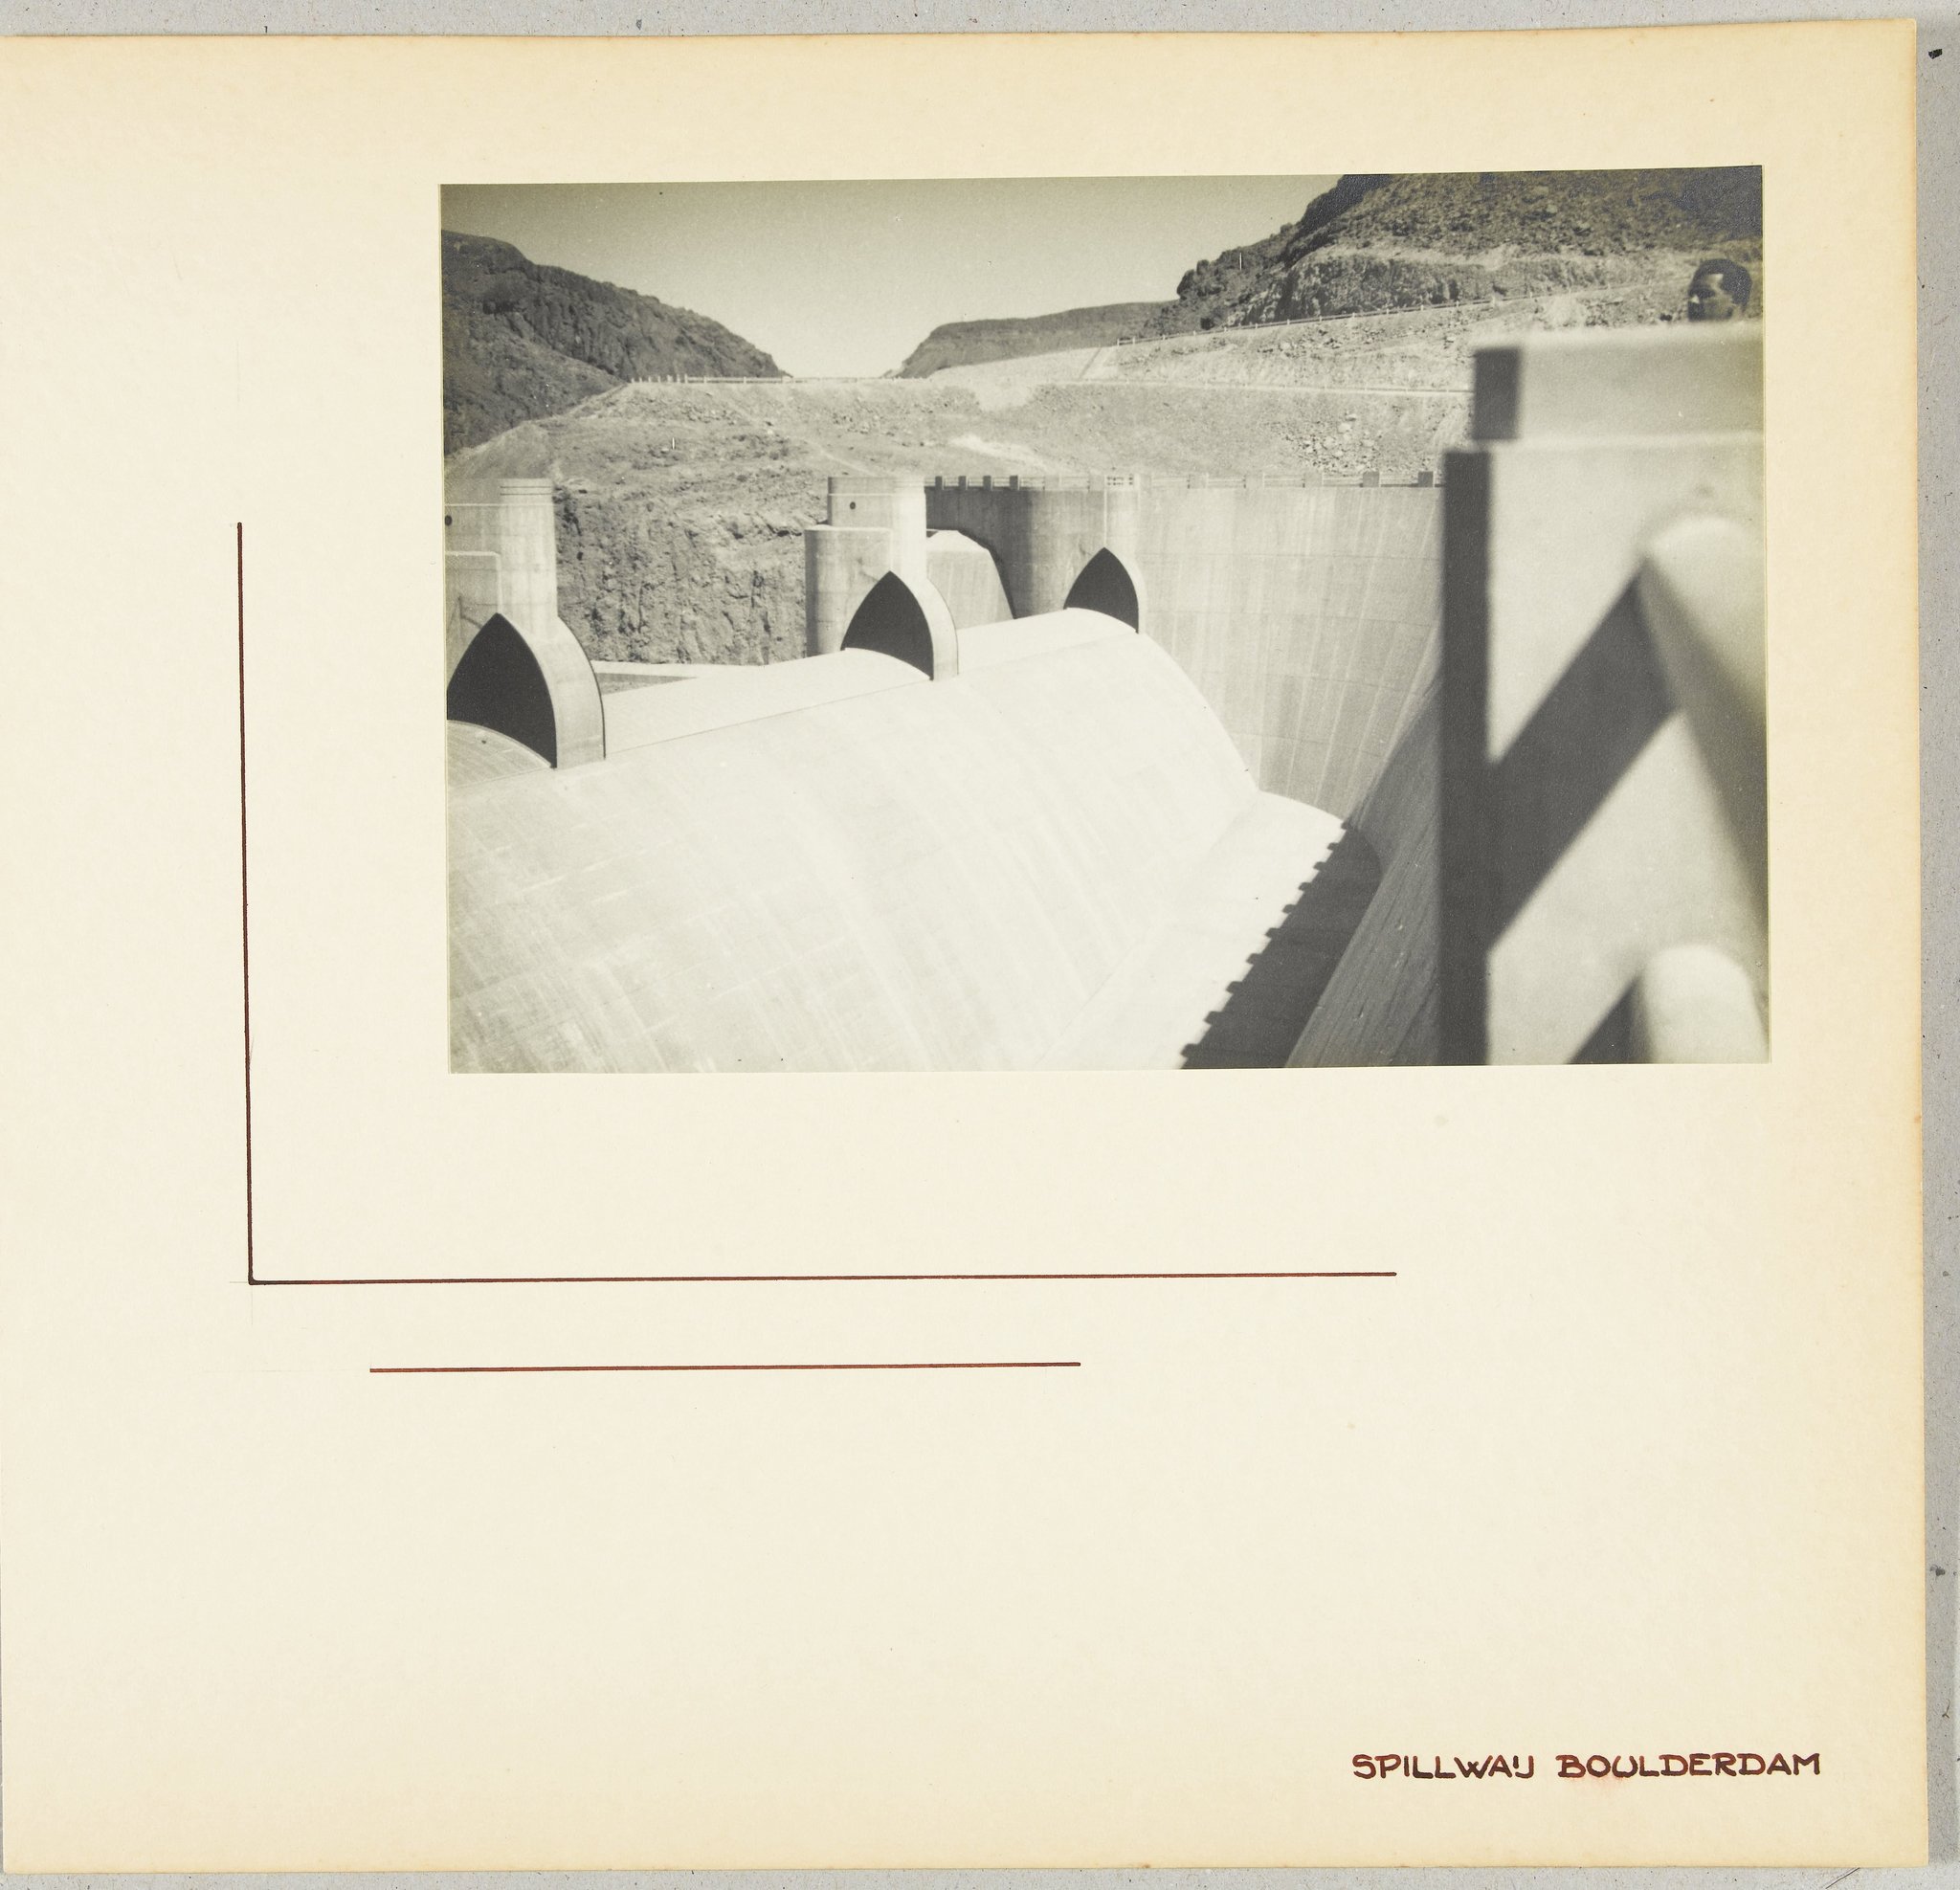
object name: photograph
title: Boulder Dam, Arizona/Nevada, Verenigde Staten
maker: wouter cool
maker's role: engineer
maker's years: 1877-1947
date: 1936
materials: cardboard, paper, photographic support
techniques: gelatin silver print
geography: united states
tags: dam (in canal)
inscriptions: title: ‘SPILLWAIJ BOULDERDAM’